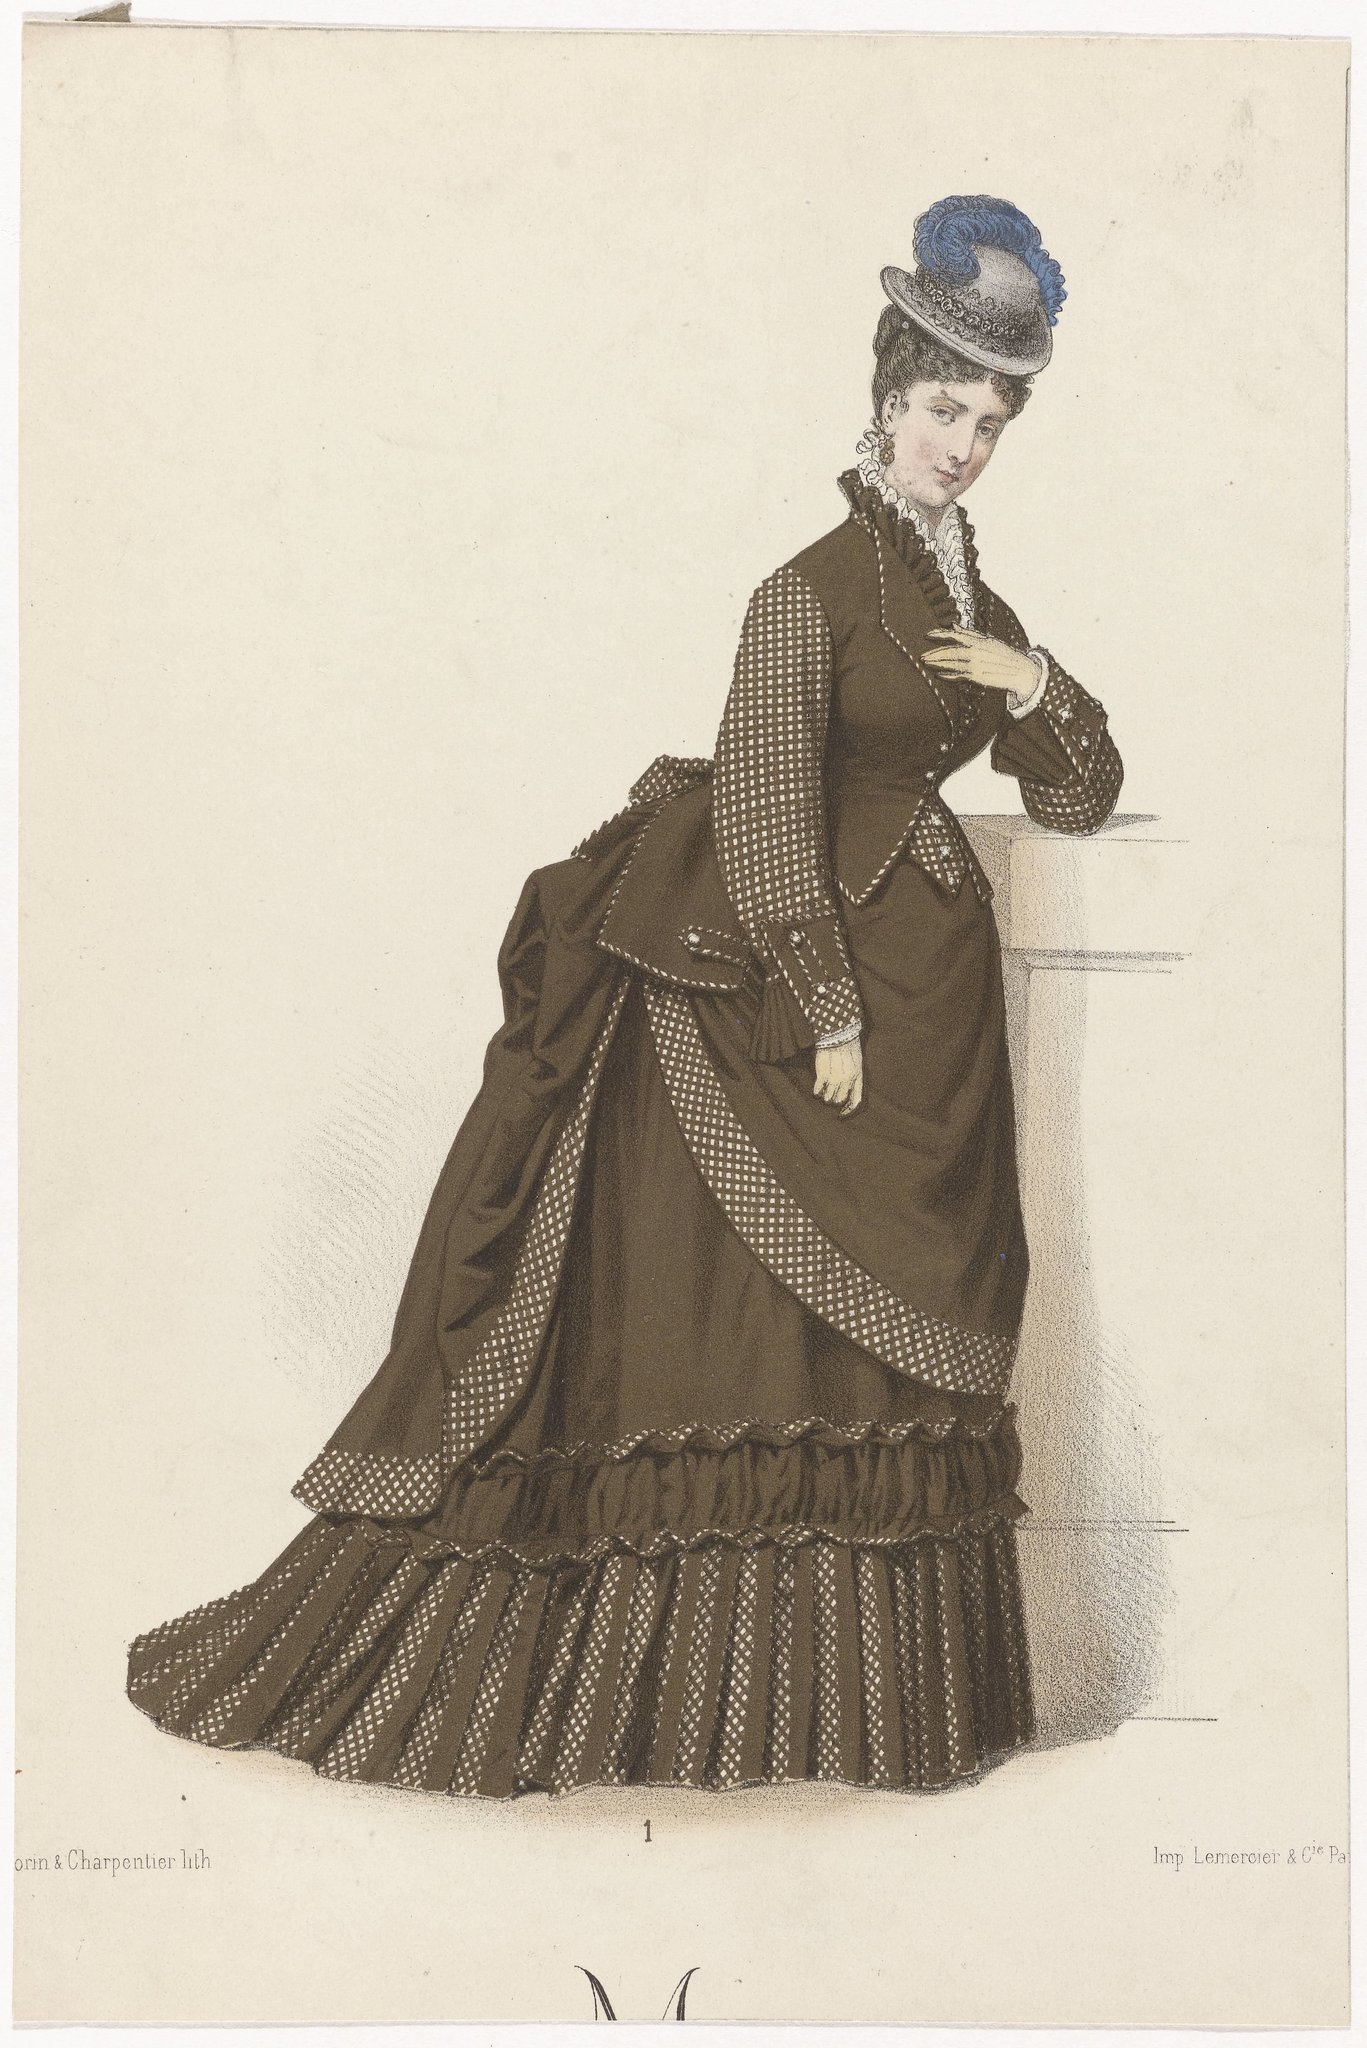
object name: fashion print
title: Dame in bruine japon, ca. 1875, No. 1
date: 1875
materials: paper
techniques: hand coloring, lithograph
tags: ear-rings (+ women's clothes), head-gear (+ women's clothes), fashion plates, skirt (+ women's clothes), gloves, mittens, etc. (+ women's clothes), dress, gown (+ women's clothes), neck-gear ~ clothing (+ women's clothes)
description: Vrouw gekleed in een bruine japon met een jasje met revers en opstaande kraag met een bijpassende rok met queue en onderrok met sleep. Verder draagt zij een hoed met opstaande rand en struisveer.